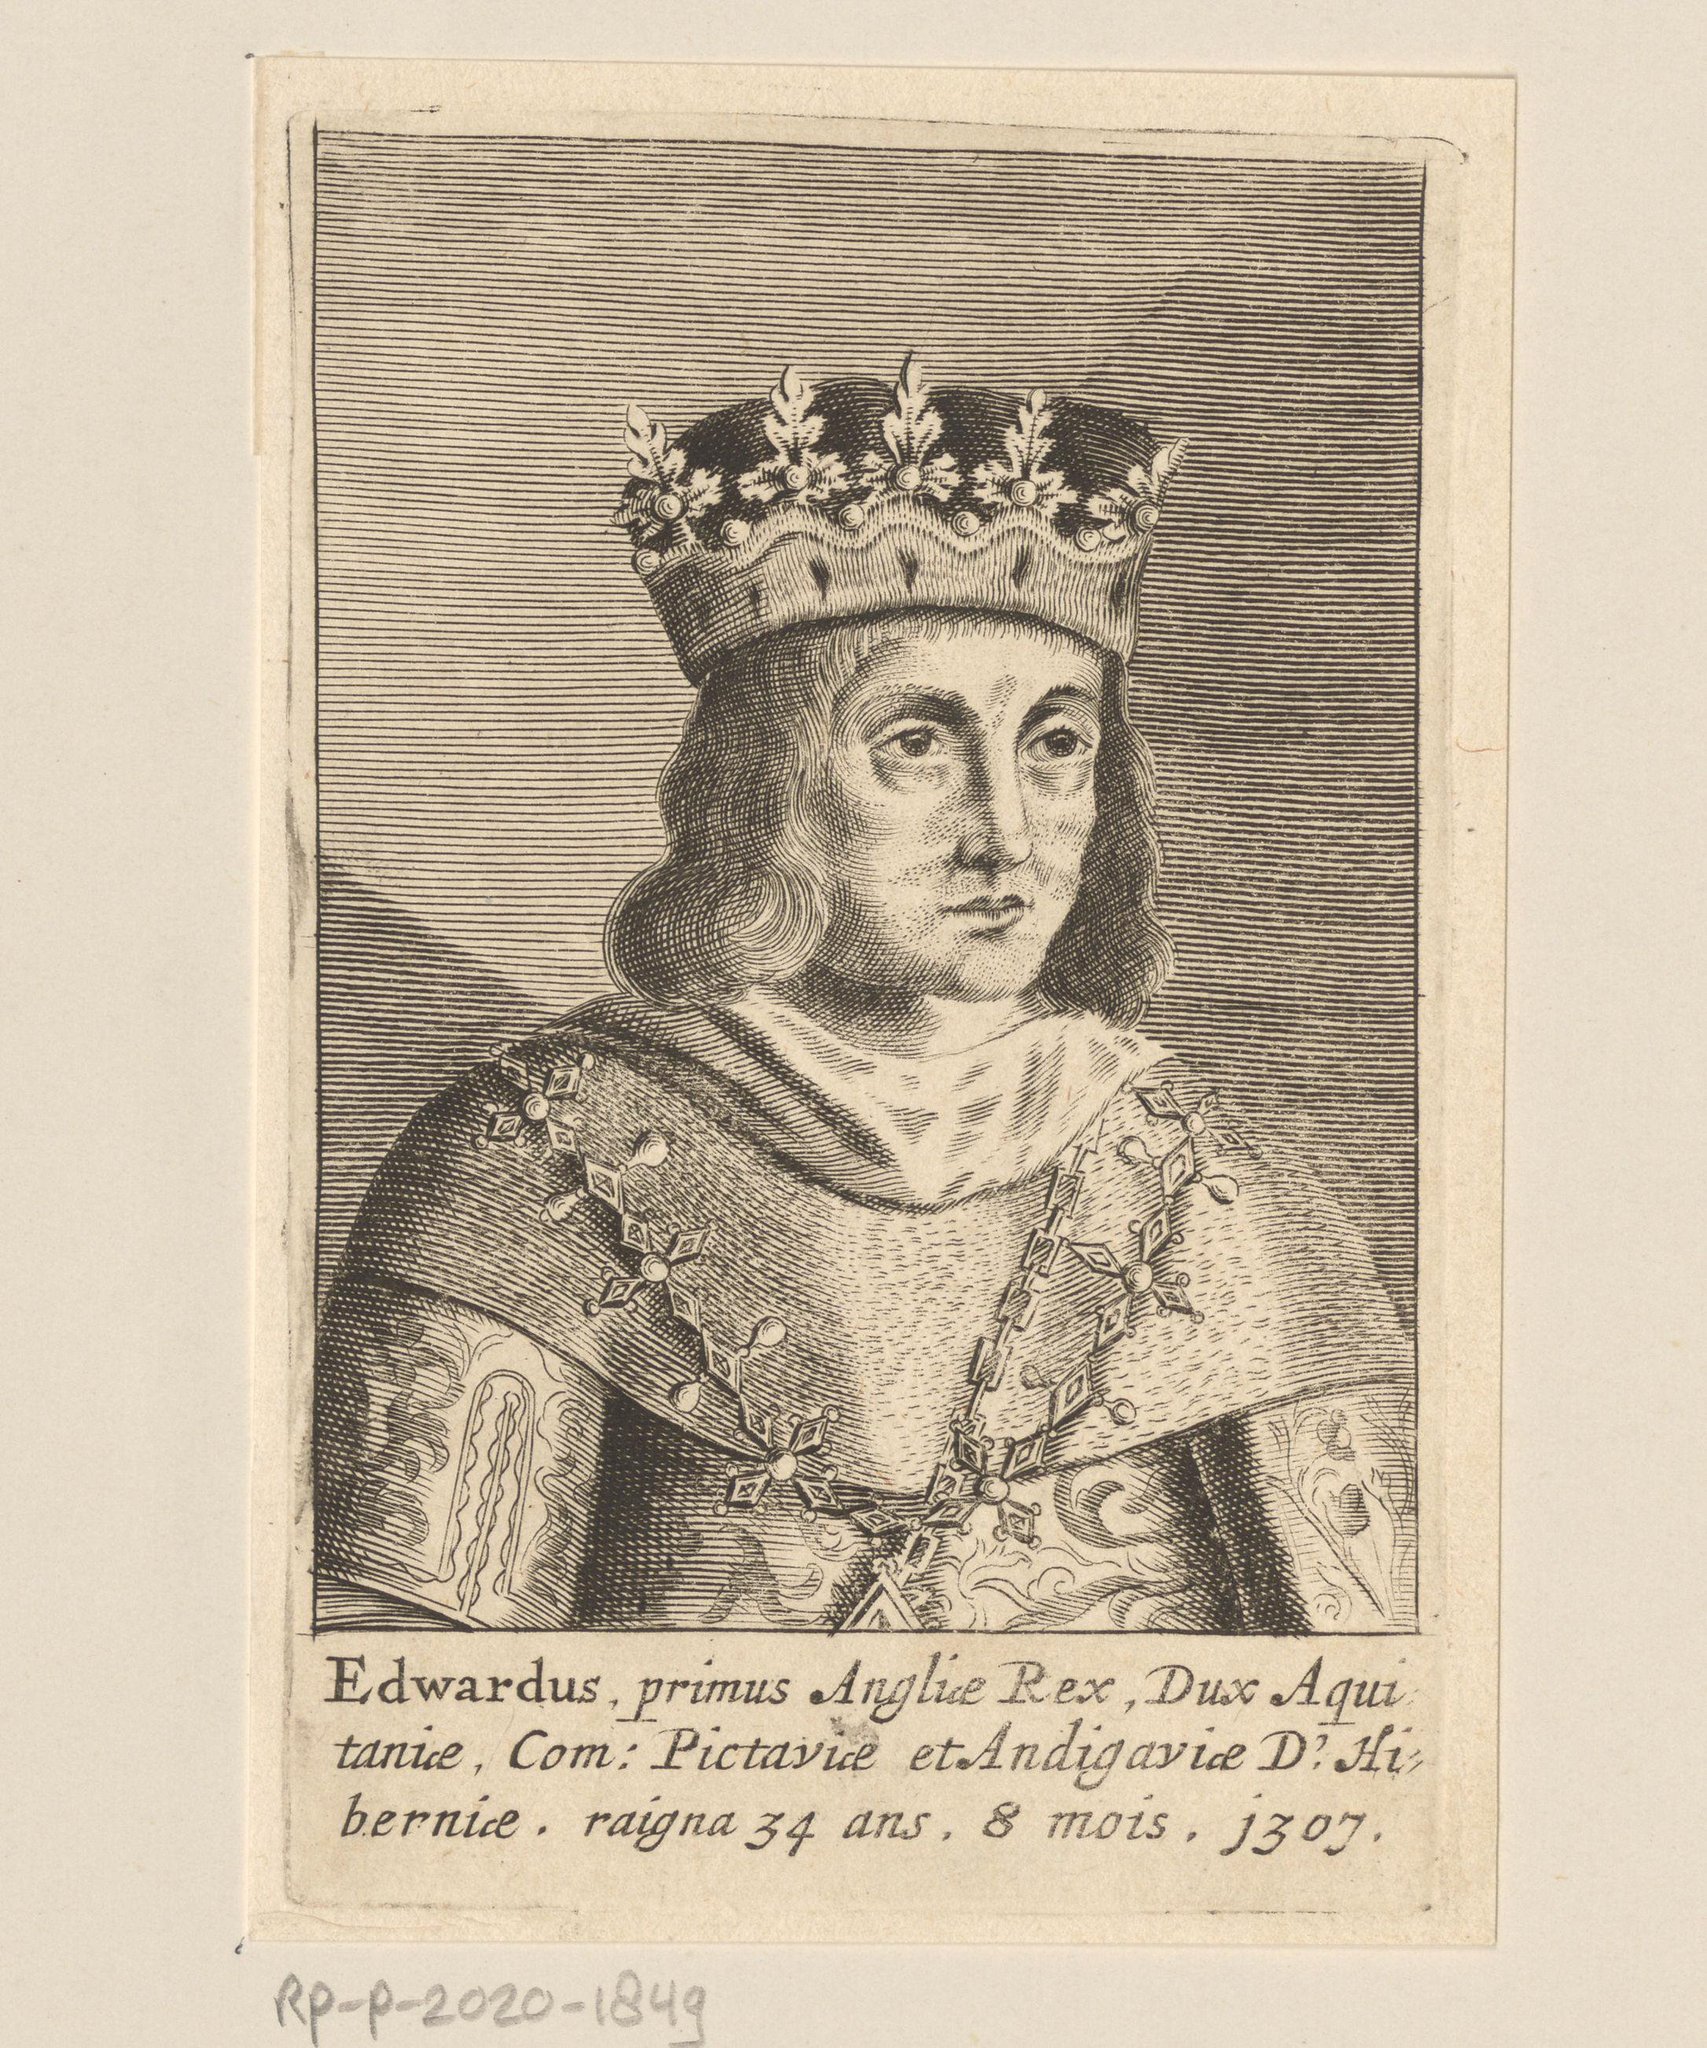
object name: print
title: Portret van Eduard I van Engeland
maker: Anonymous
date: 1649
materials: paper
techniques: engraving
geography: northern netherlands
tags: crown (symbol of sovereignty), historical persons, king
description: Prent met tekst op verso gebruikt in: Baker, Richard. Cronyke van het leven en bedryff van alle de coningen van Engeland (...). Amsterdam: Cornelis Dankertz., 1649, p. 158.